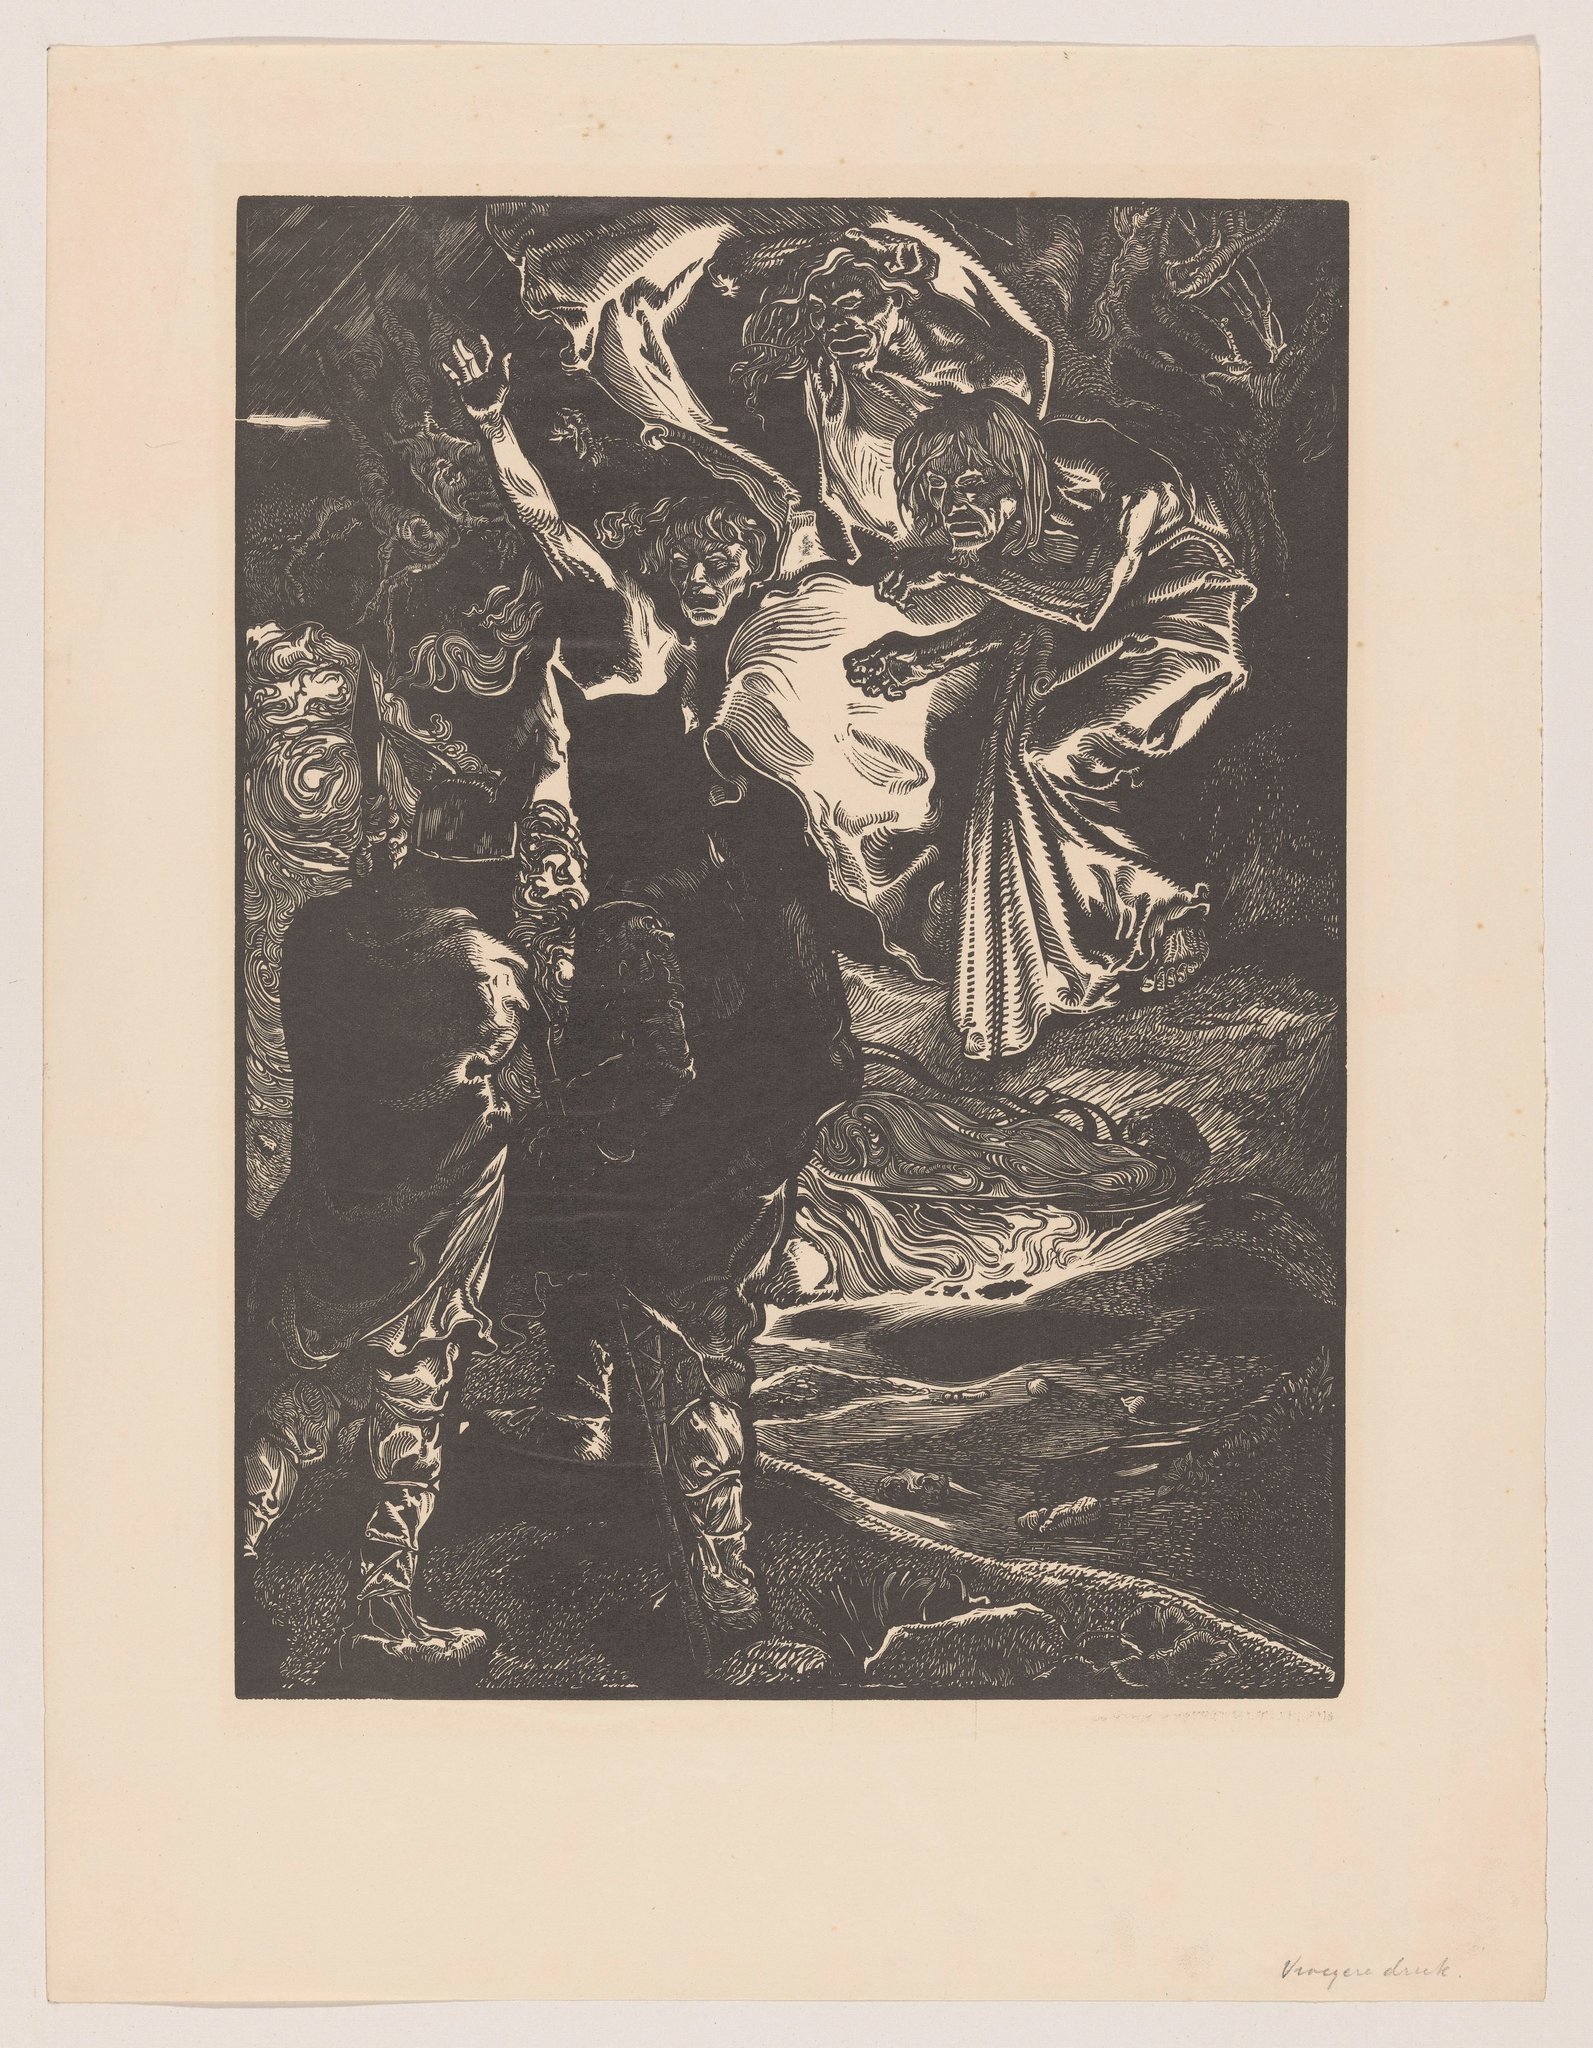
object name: print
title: Compositie met heksen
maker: johannes josephus aarts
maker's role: draughtsman, print maker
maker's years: 1871-1934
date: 1881-1934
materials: paper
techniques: woodcut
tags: groups of witches, macbeth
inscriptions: collector's mark: Lugt 2166, annotation: ‘Vroegere druk.’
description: Linksonder Macbeth en zijn vriend Banquo, rechtsboven de drie heksen die voor elk van hen voorspellingen in petto hebben.